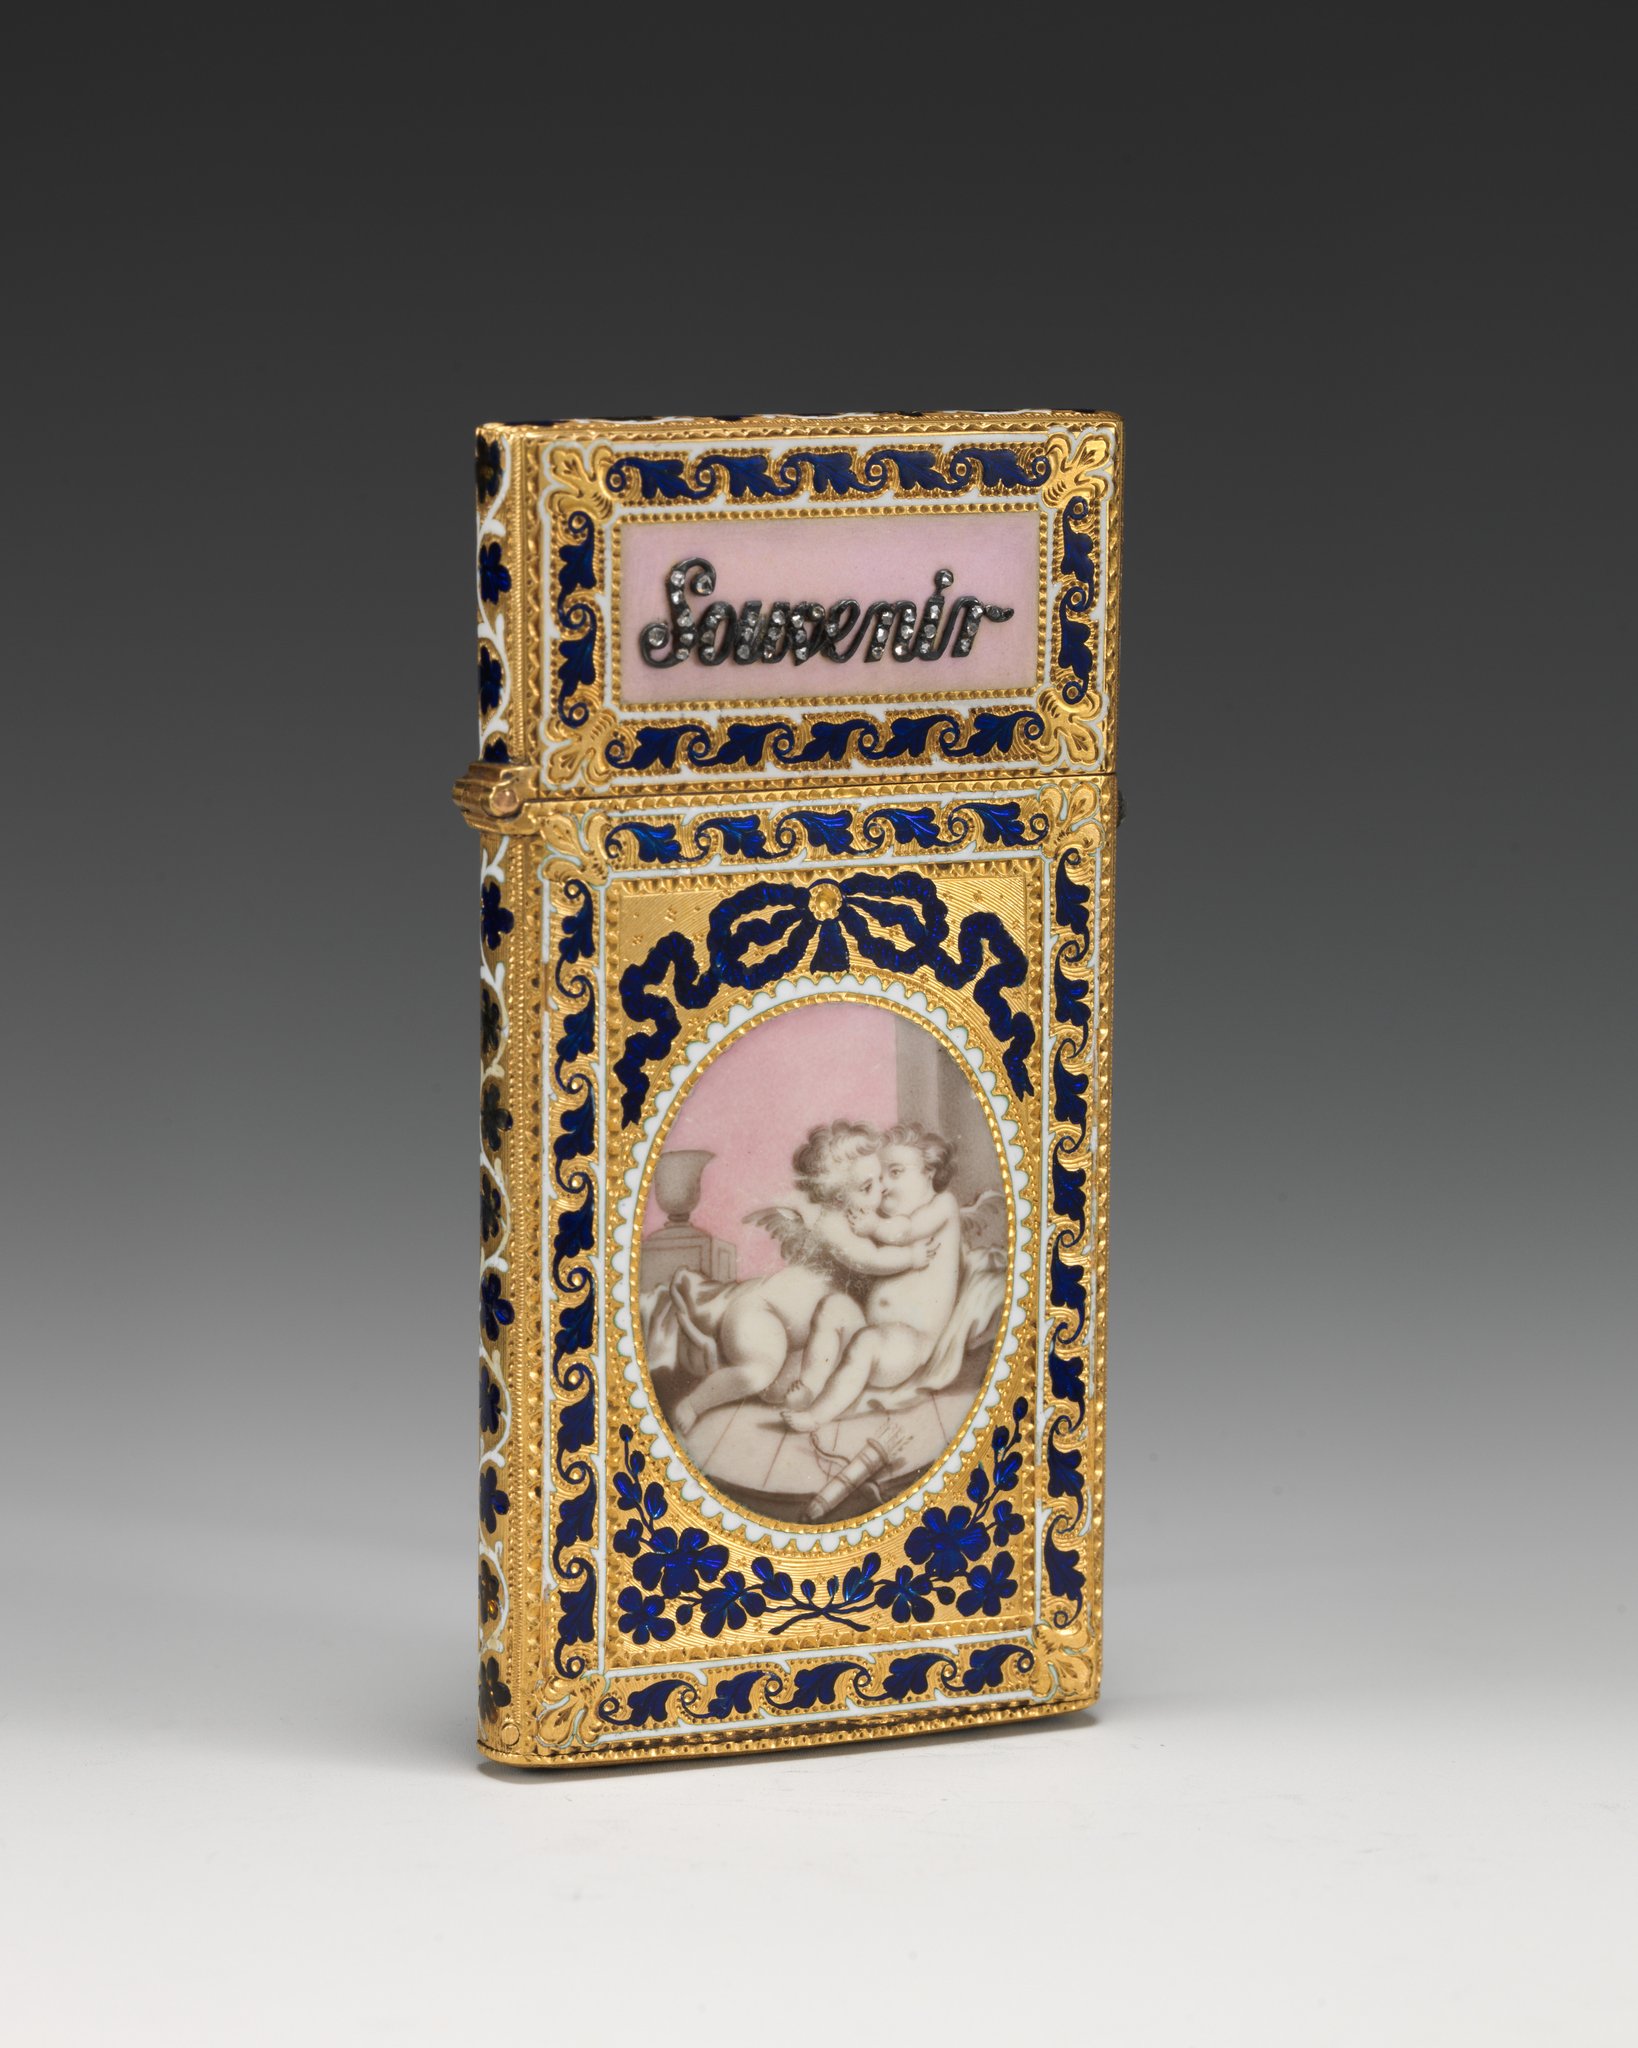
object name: souvenir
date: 1770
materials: diamond, enamel, gold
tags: cupid